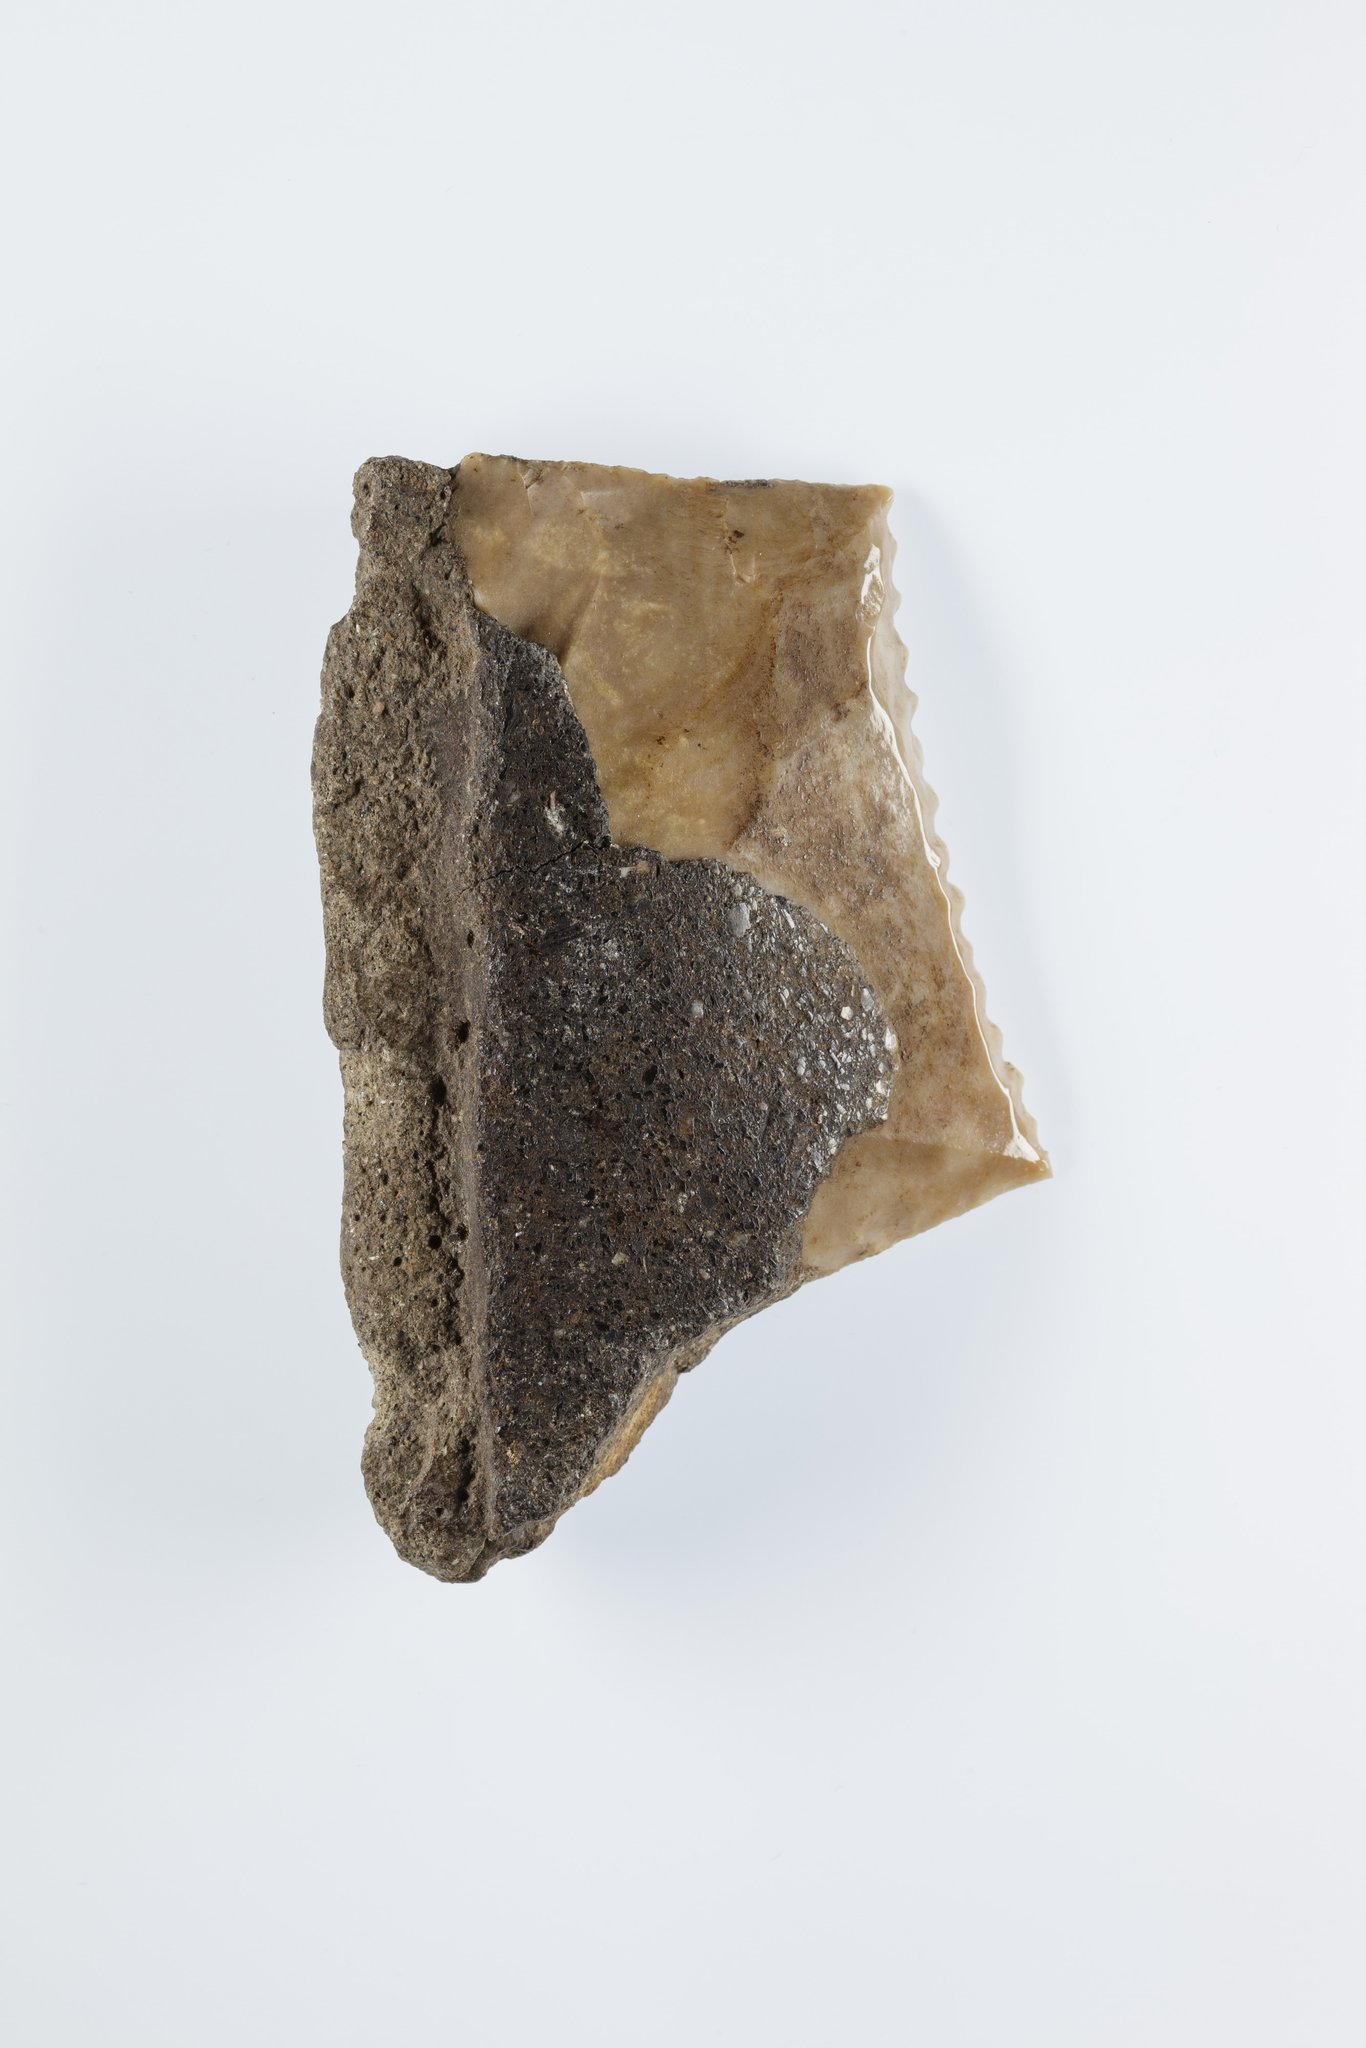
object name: sickle, denticulate, truncated, backed, geometric, tool, element, adhesive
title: Sickle Insert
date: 1186-1070 BCE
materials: stone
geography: egypt